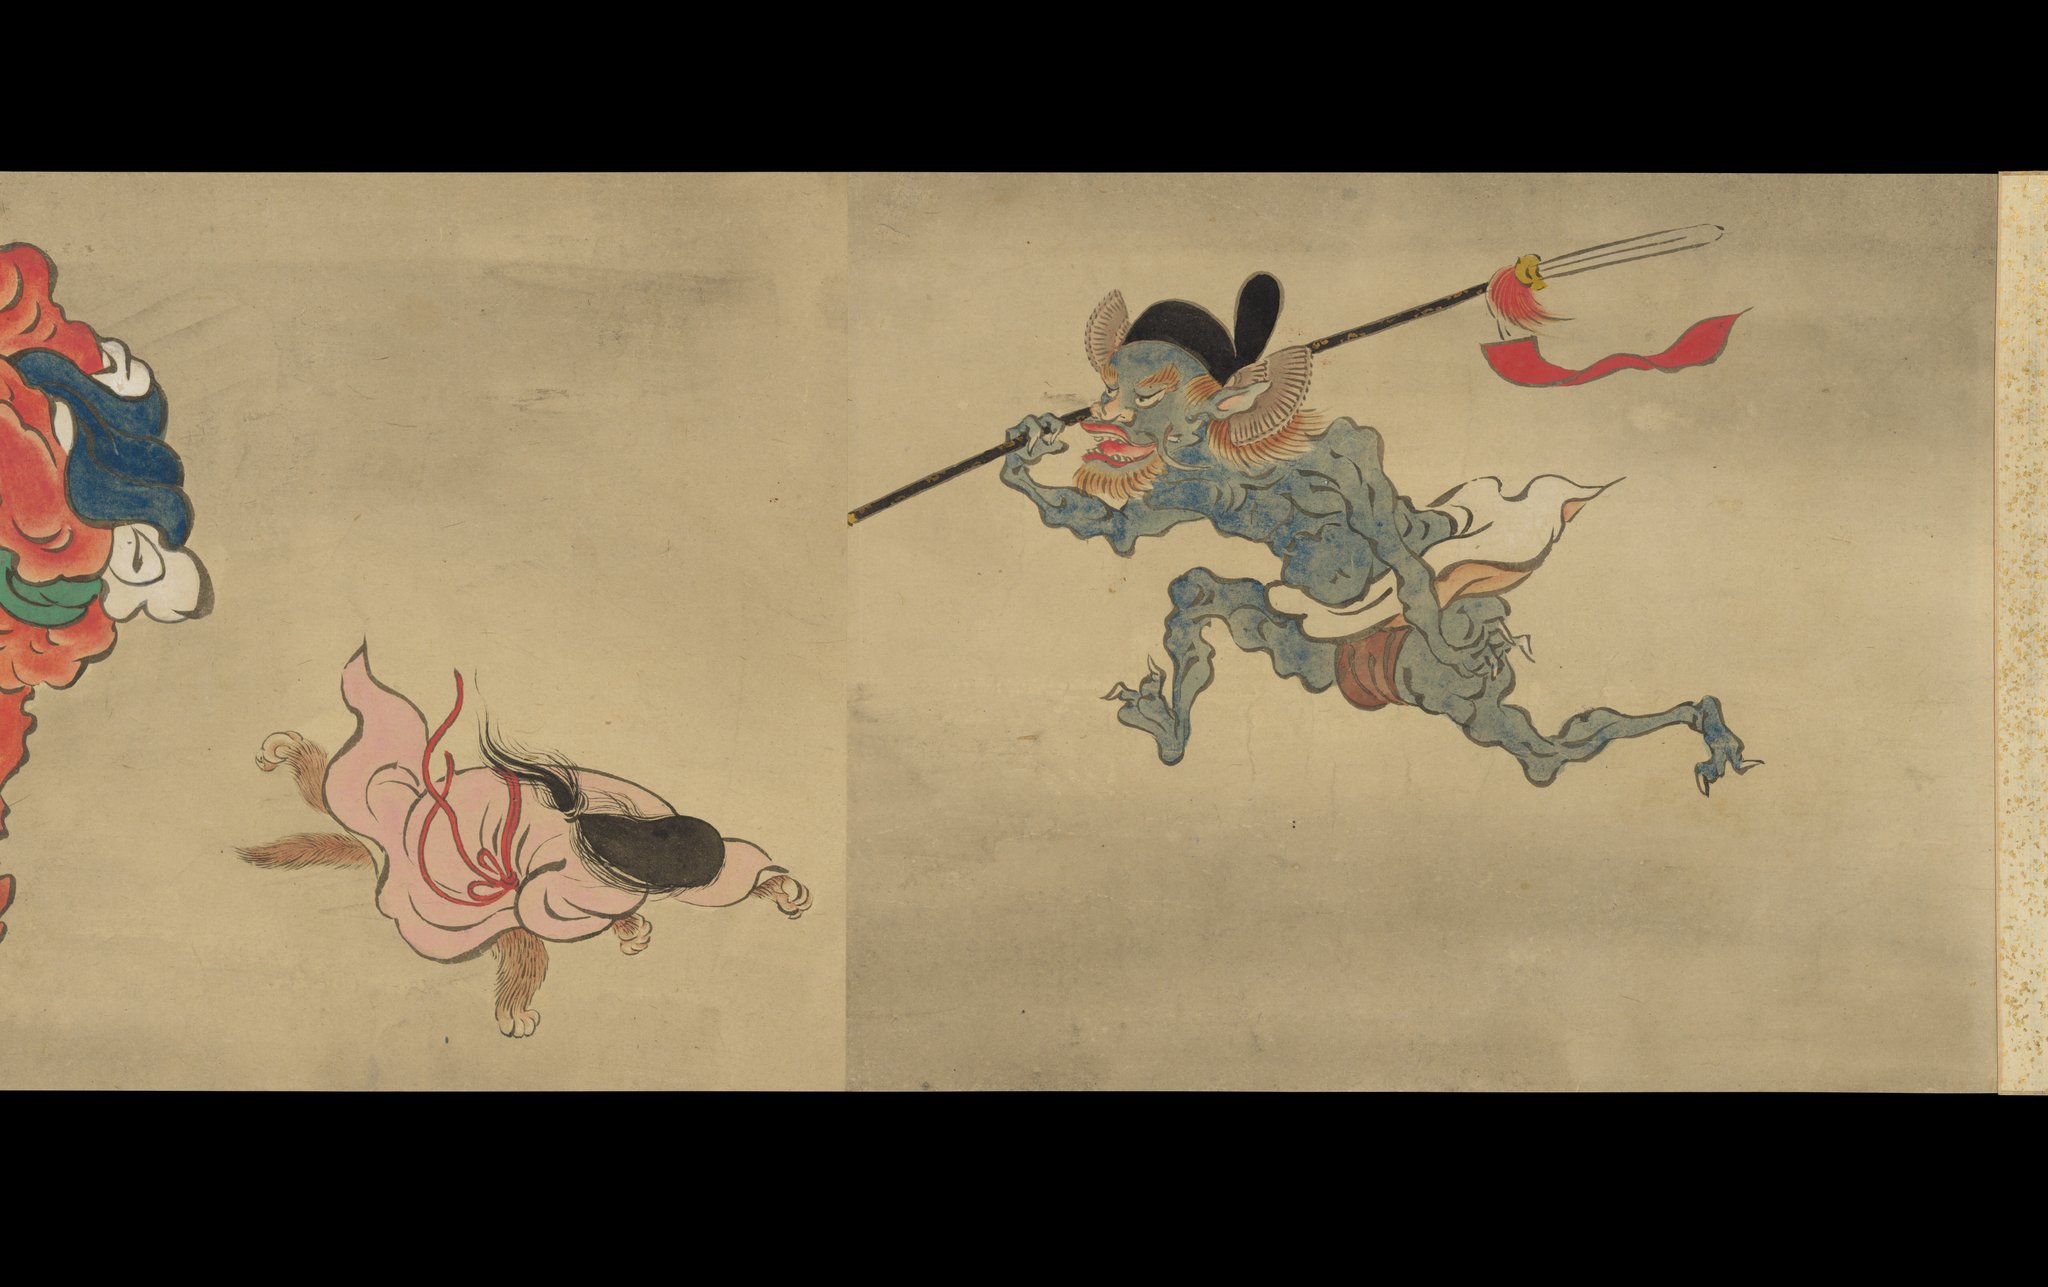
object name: handscroll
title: Copy of Night Parade of One Hundred Demons from the Shinjuan Collection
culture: japanese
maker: mochizuki gyokusen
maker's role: artist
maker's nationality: japanese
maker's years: 1692-1755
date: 1701-1800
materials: ink, paper